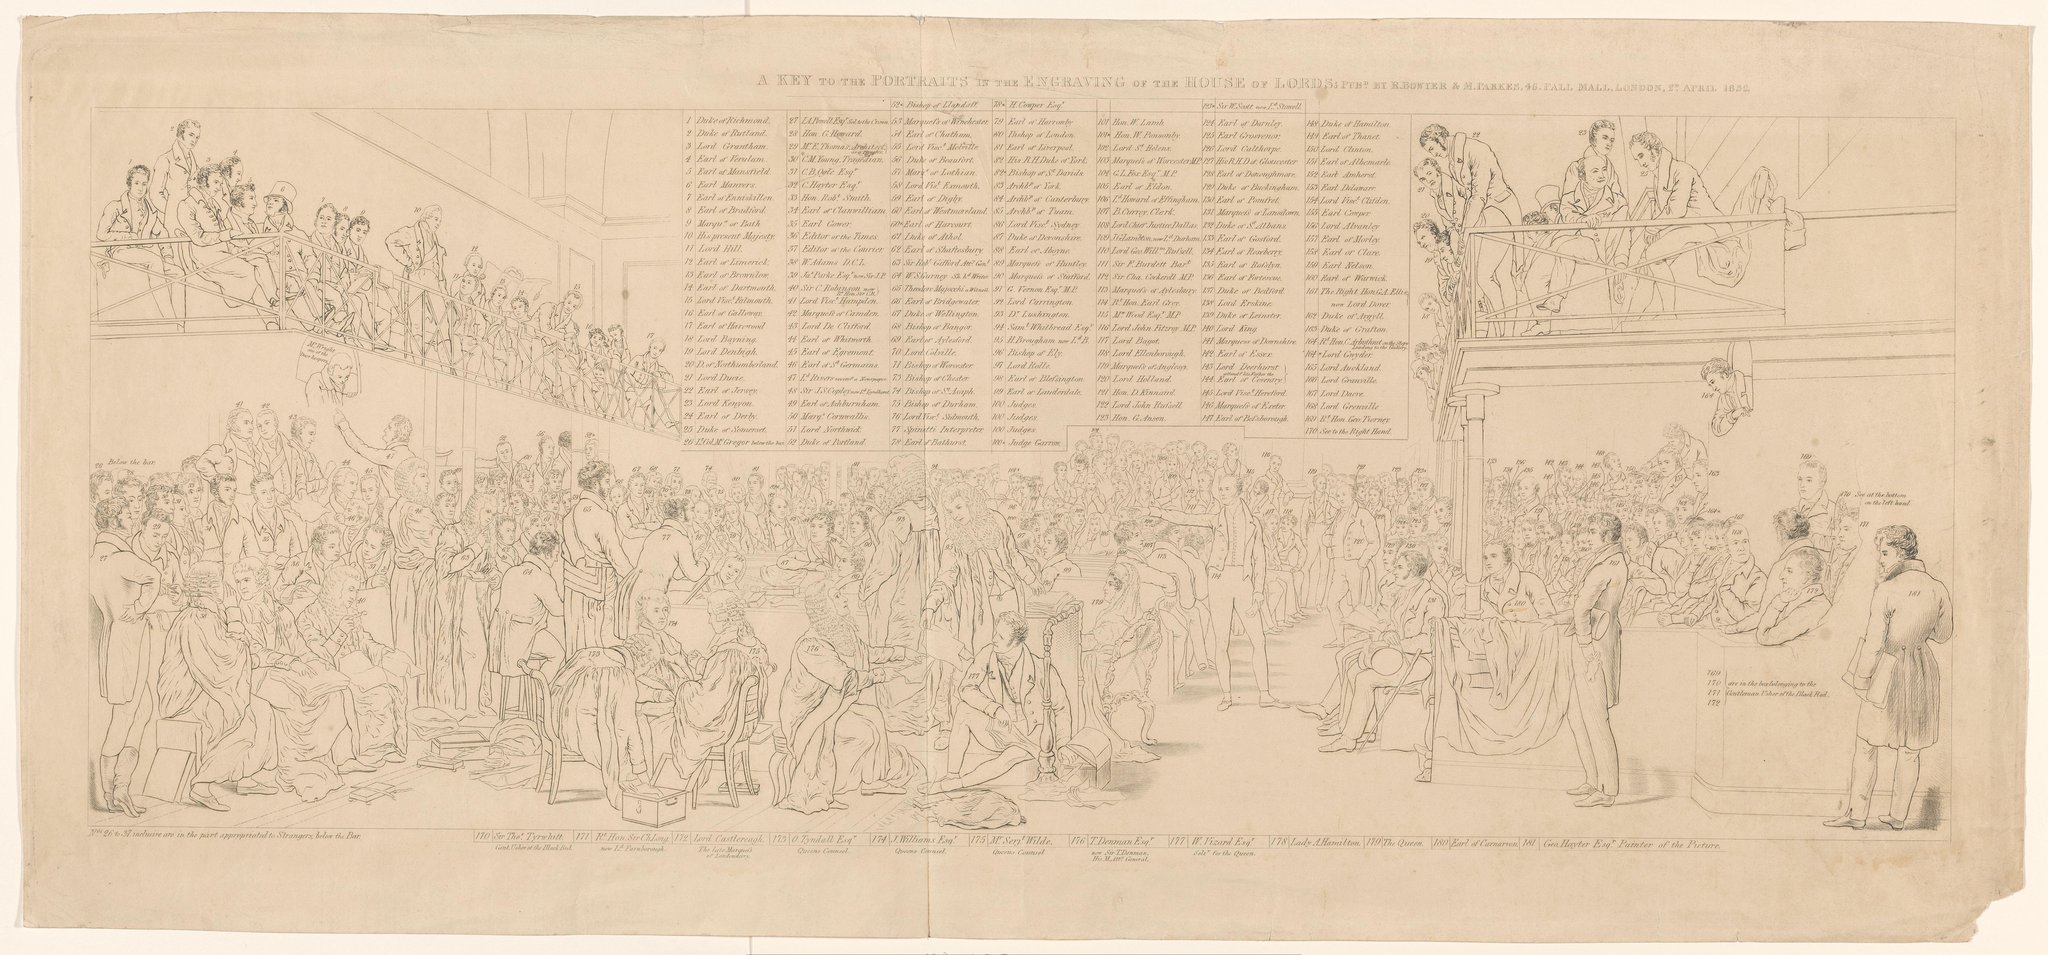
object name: print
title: A Key to the Portraits in the Engraving of the House of Lords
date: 1832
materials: paper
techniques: etching, roulette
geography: england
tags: administration of justice, trial, upper house, senate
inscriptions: collector's mark: Lugt 2228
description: Sleutel voor de prent van een bijeenkomst van het Britse Hogerhuis tijdens de rechtszitting tegen koningin Caroline van Brunswijk, 1820. Alle figuren in contouren, met de namen in de legenda 1-181. Behorend bij de prent van John Charles Bromley naar het schilderij door George Hayter (niet in de collectie).